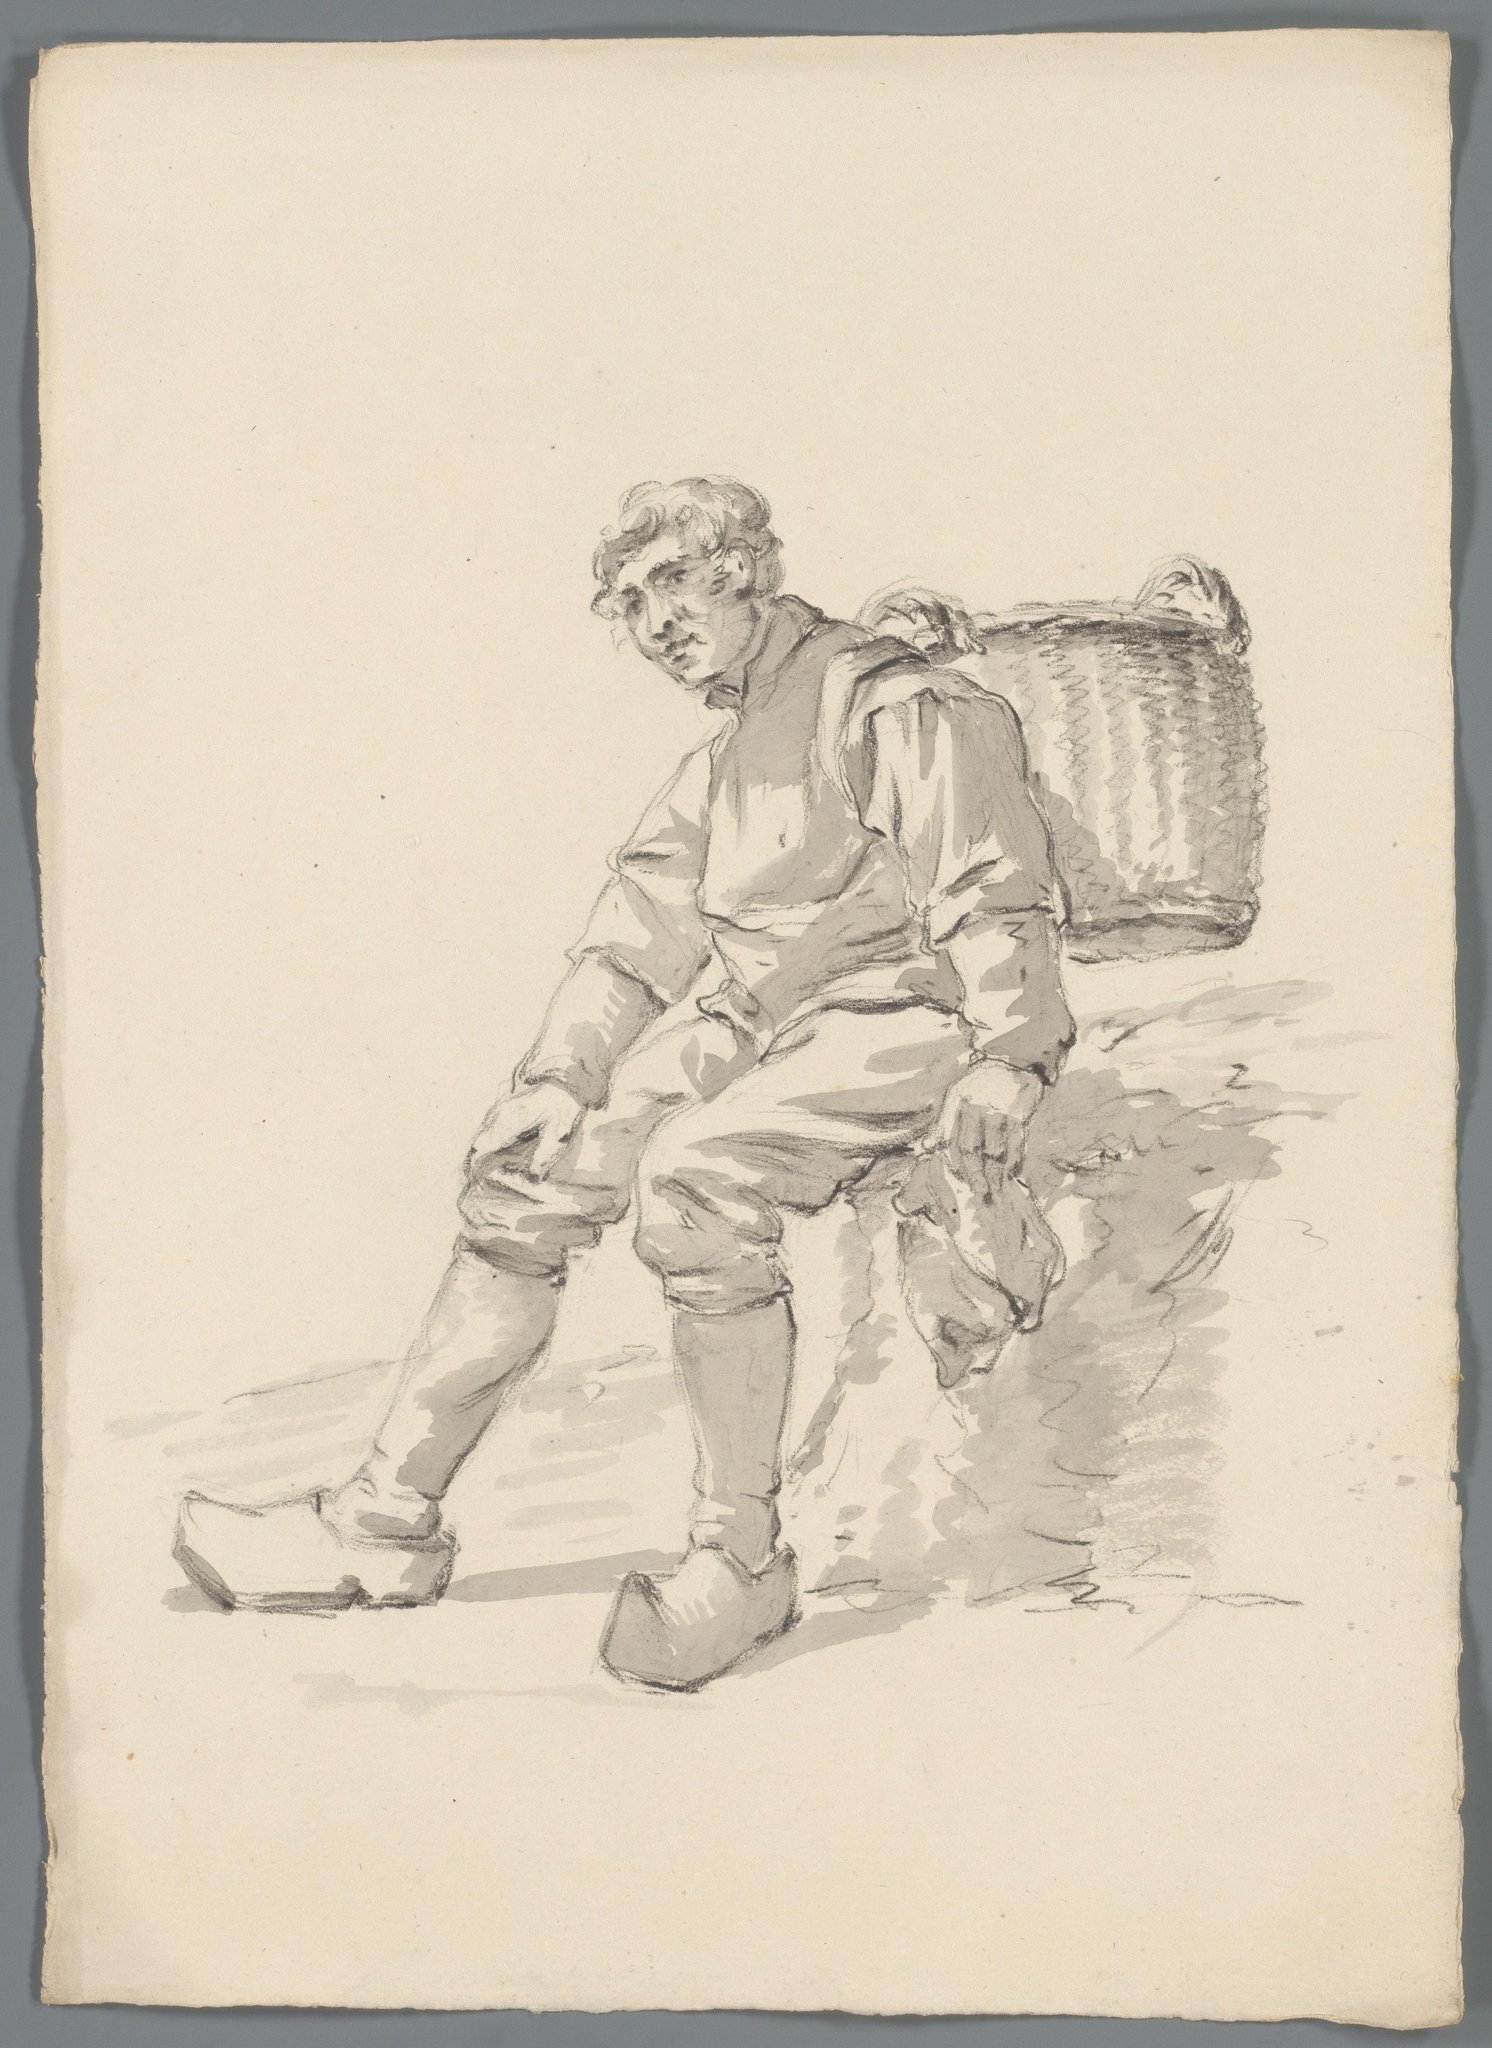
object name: drawing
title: Zittende man met een mand op zijn rug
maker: Anonymous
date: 1820-1830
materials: chalk, paper, watercolor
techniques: brush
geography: the hague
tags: sitting figure, wooden shoes, clogs, adult man, container made of plant material other than wood: basket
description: Tekeningen waarschijnlijk ontstaan bij het Haagse kunstgenootschap ‘Tot Nut der Tekenkunst’, waar twee keer per week tekenavonden werden georganiseerd met geklede modellen.